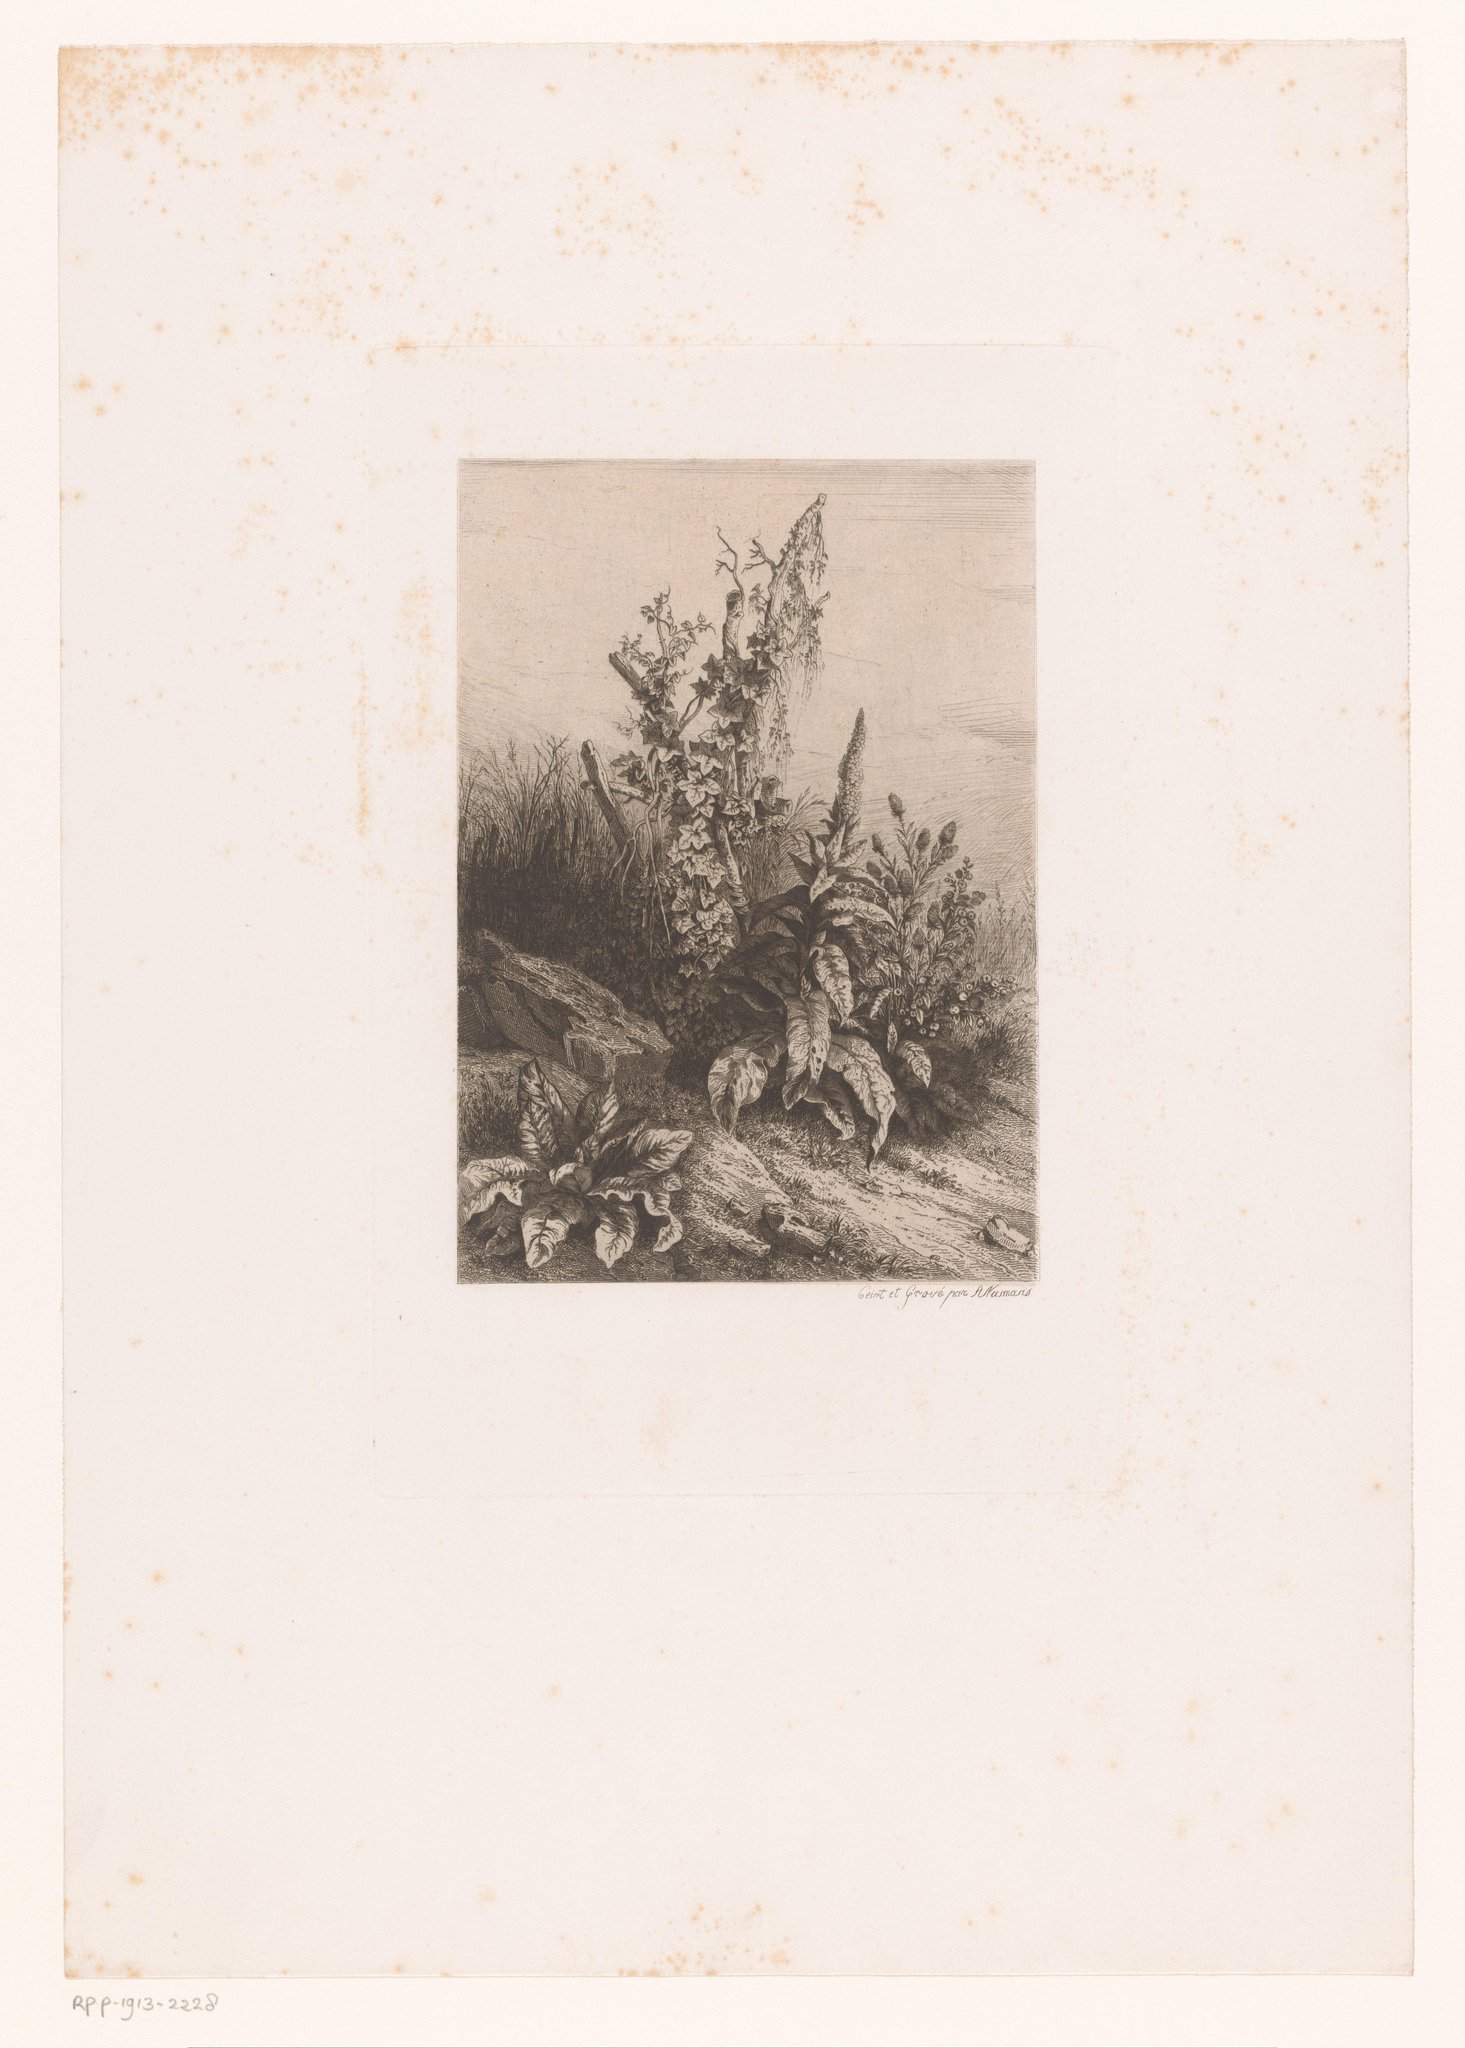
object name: print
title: Klimplanten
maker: auguste numans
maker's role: print maker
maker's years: 1823-1883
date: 1833-1879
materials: paper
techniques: etching, intaglio, roulette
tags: plants; vegetation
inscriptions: collector's mark: Lugt 2228